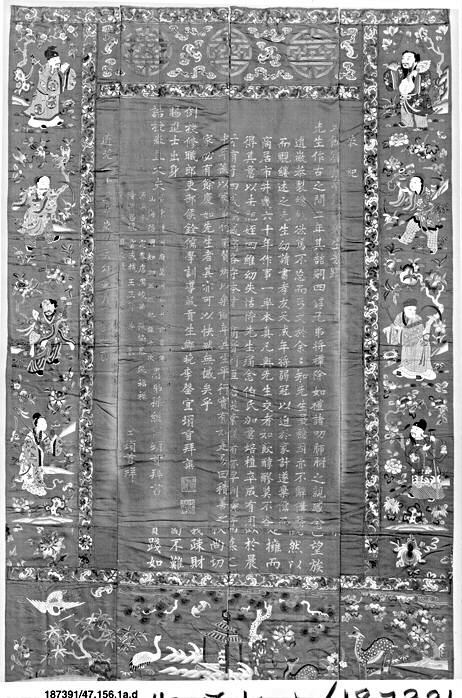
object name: hanging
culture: chinese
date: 1844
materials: gold, gold paint, silk, thread